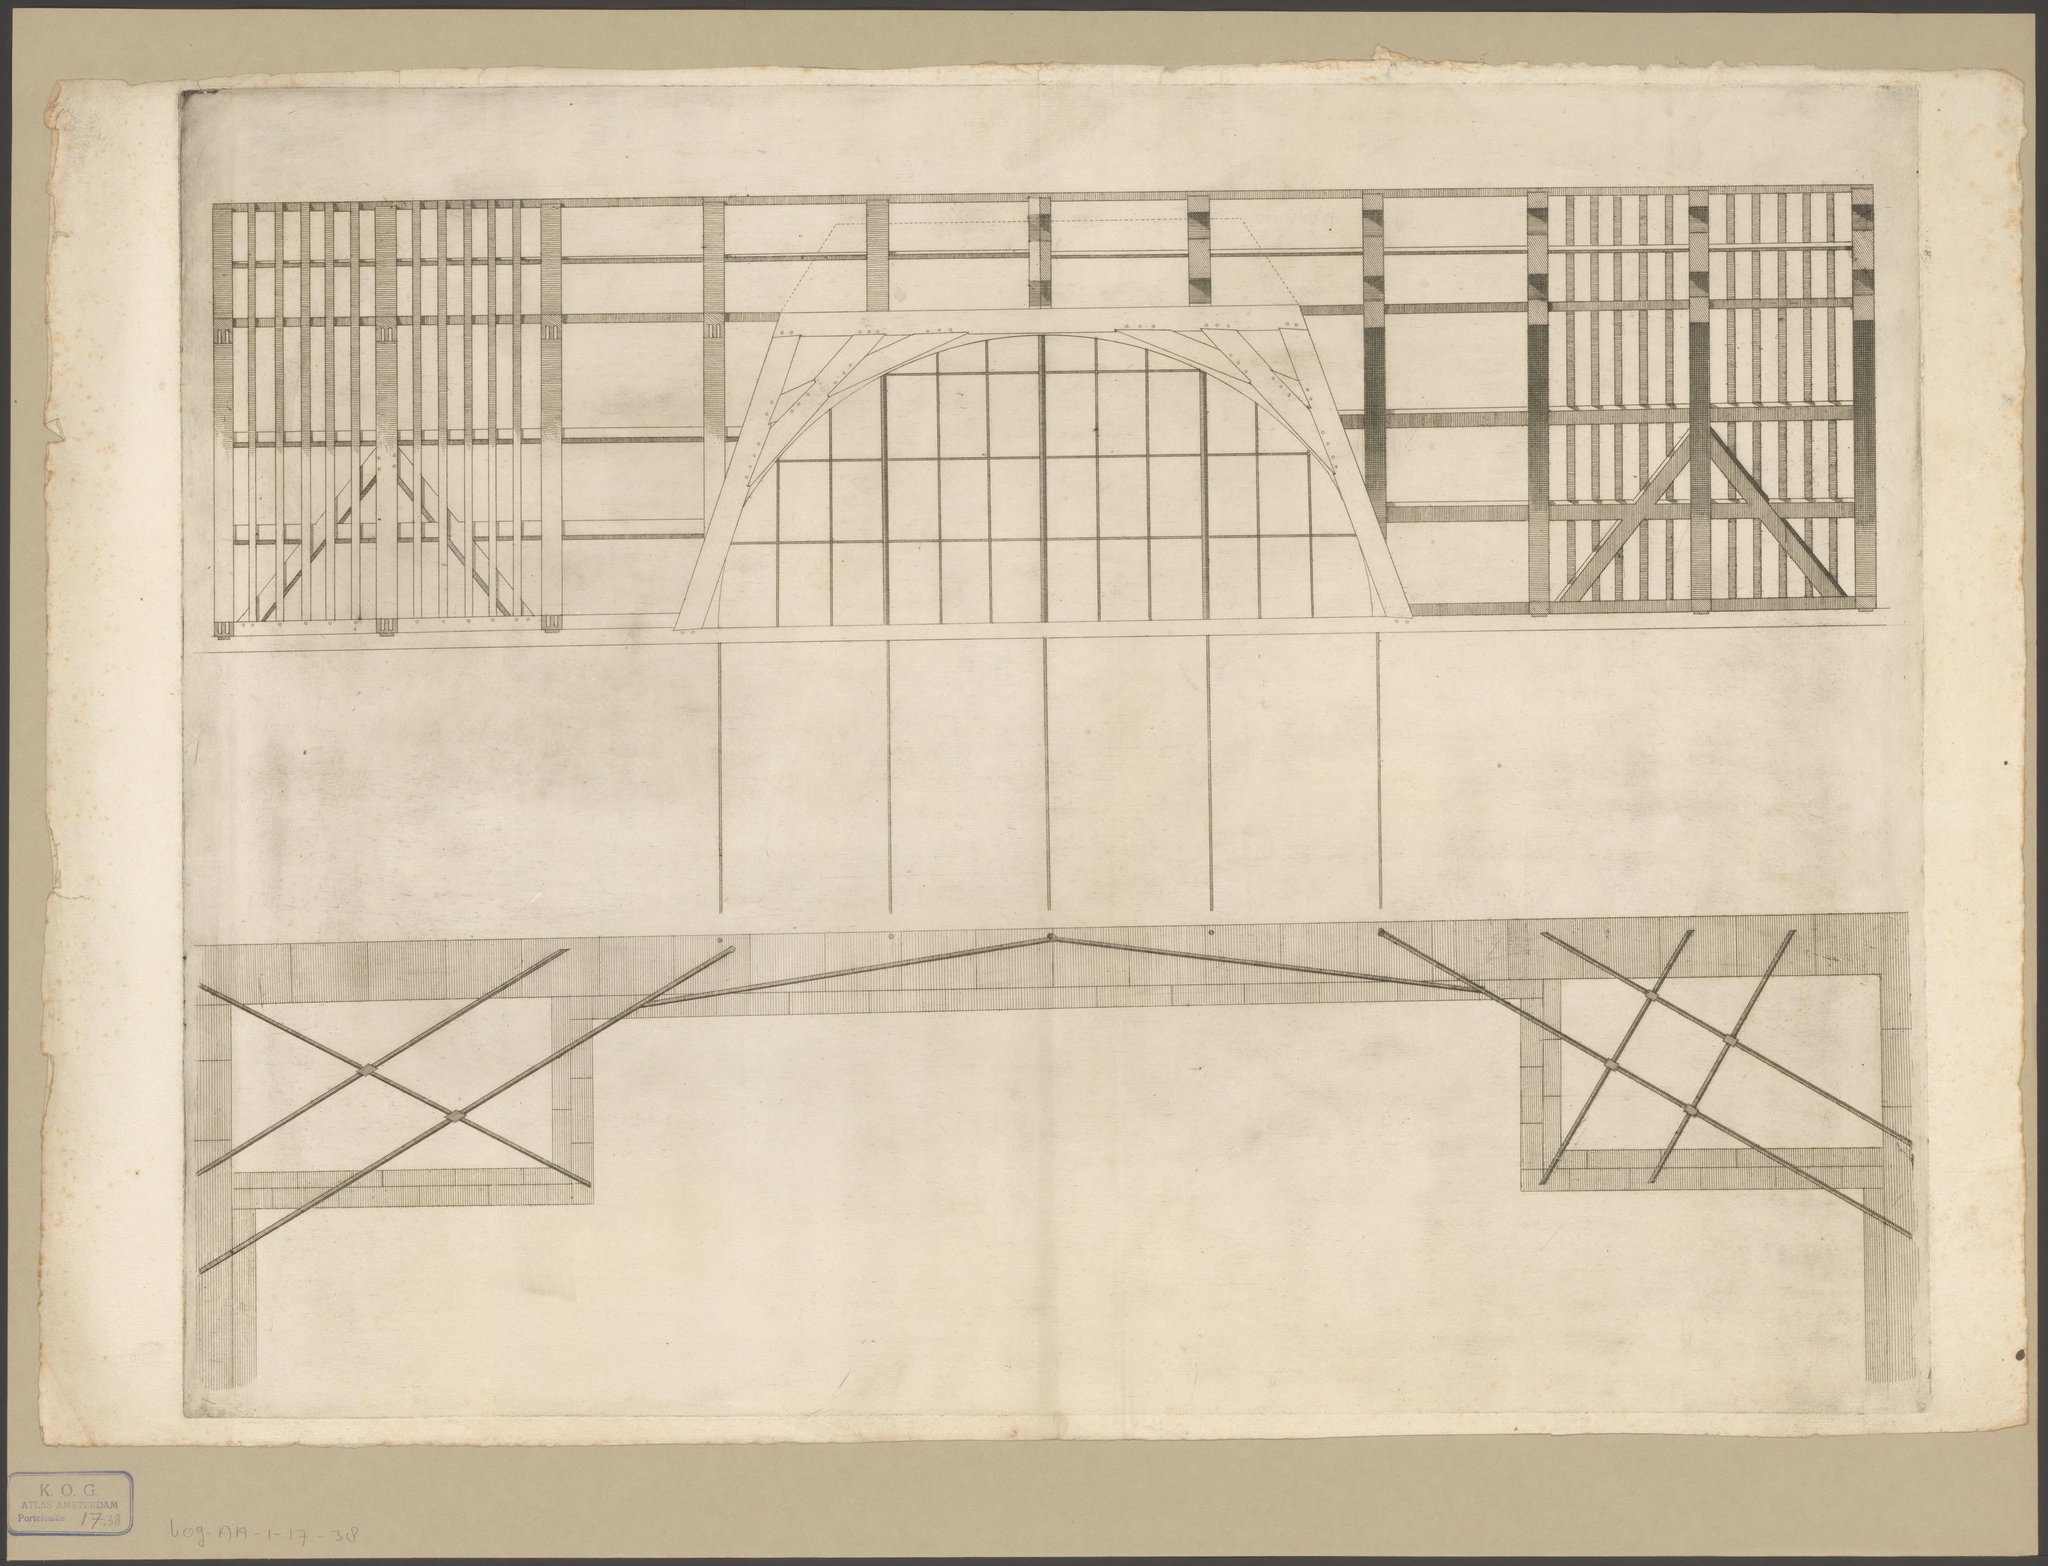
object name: print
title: Ontwerp voor de constructie van het dak van de Burgerzaal in het Stadhuis op de Dam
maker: Anonymous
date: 1600-1650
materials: paper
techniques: etching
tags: roof (of house or building), townhall, plan ~ architecture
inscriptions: collector's mark: ‘17.38’ Lugt 1641b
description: Onderwerpsrubriek binnen de Atlas Amsterdam: Nieuwe Stadhuis, van binnen: Kap, Plattegronden, Betimmering.